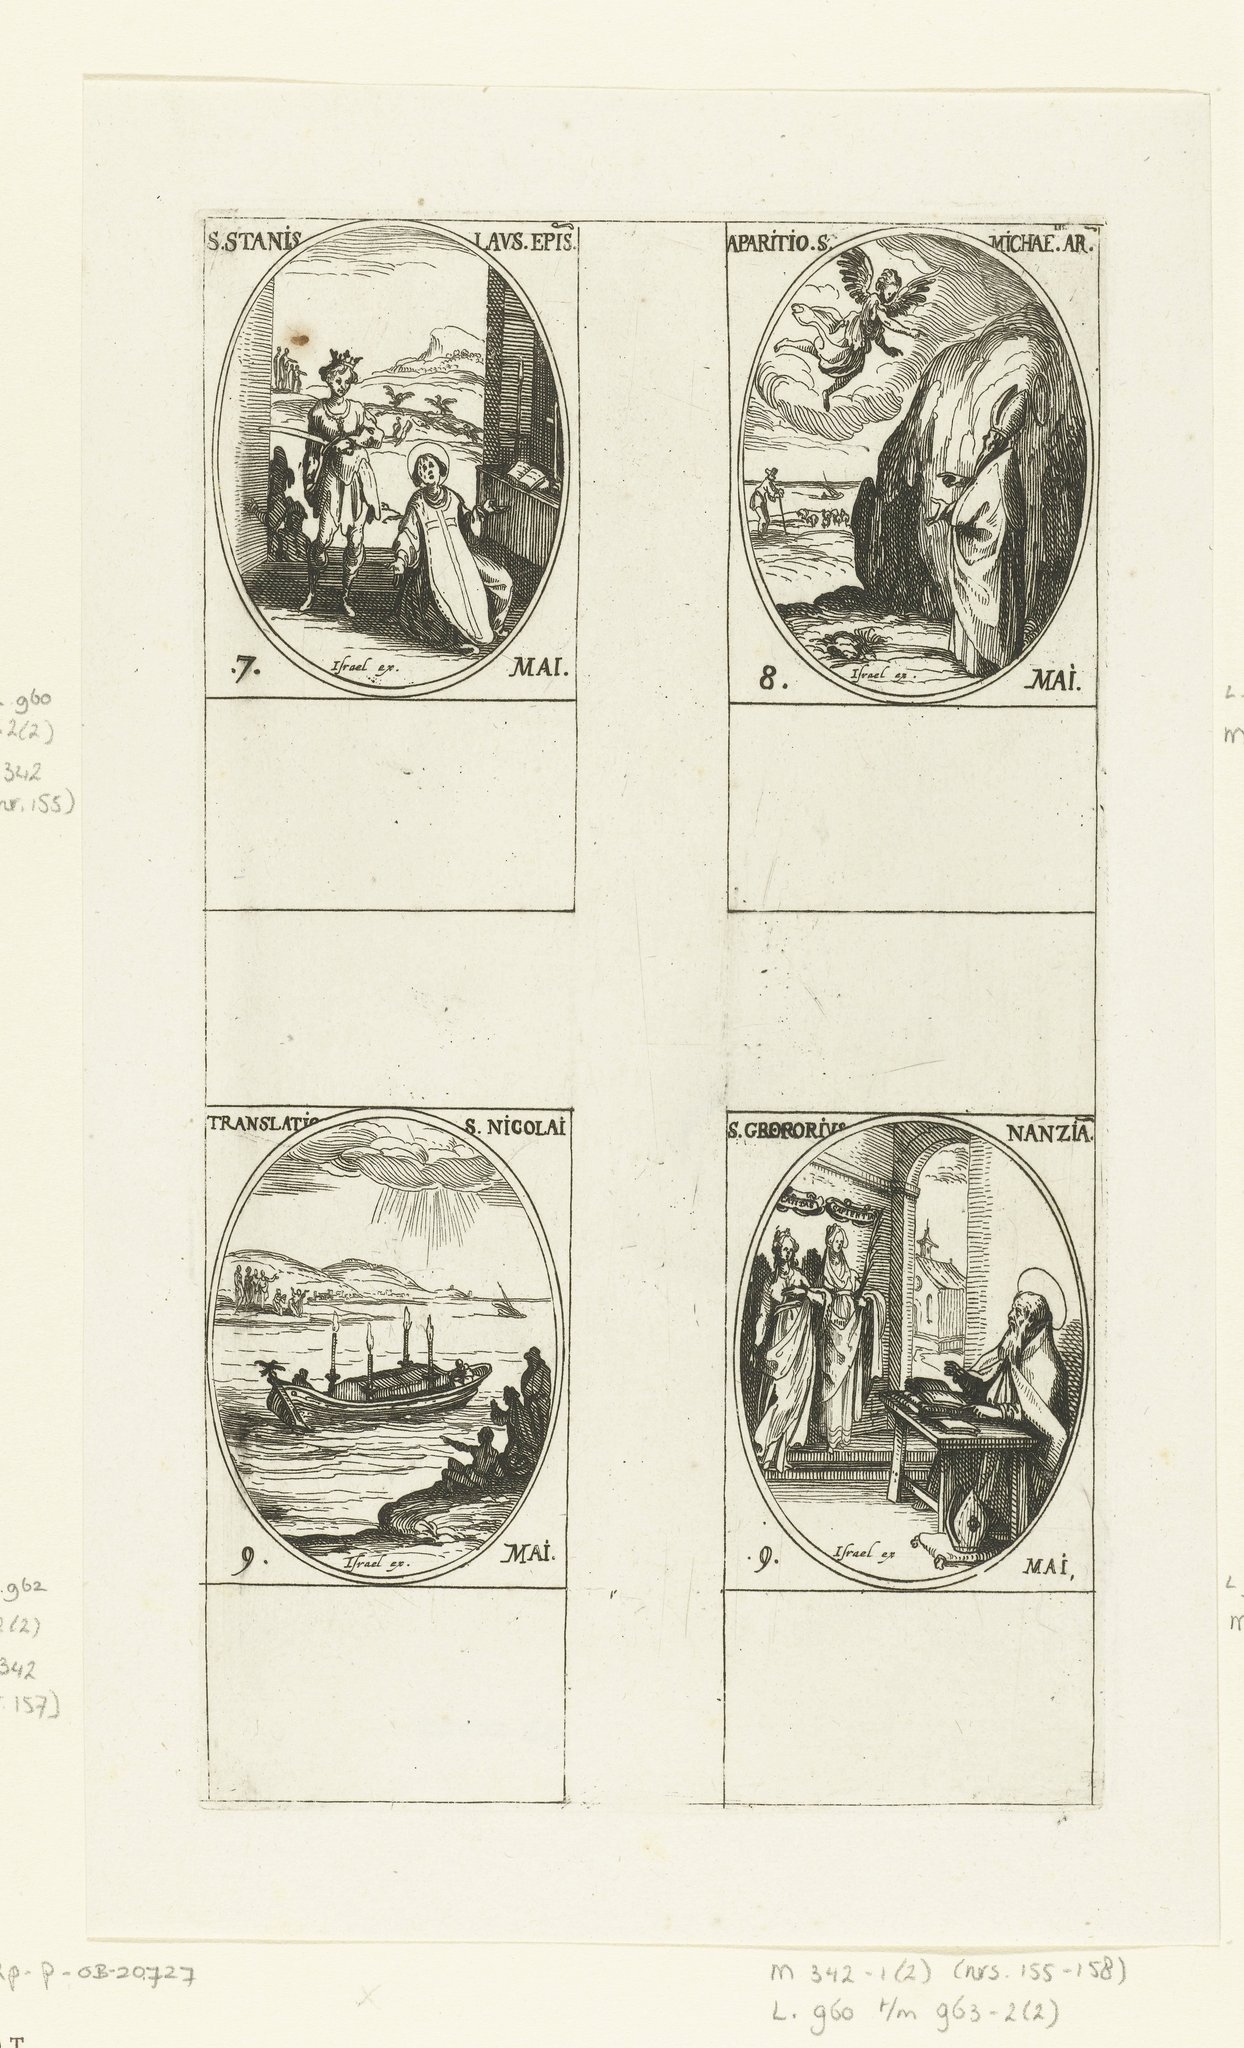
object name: print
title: Alle heiligen en de Christelijke feestdagen van het jaar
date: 1632-1636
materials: paper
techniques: etching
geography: paris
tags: the bishop nicholas of myra (or bari); possible attributes: anchor, boat, three golden balls (on a book), three purses, three children in a tub, three maidens, the monk and bishop gregory of nazianzus, also called the theologian; possible attributes: book, scroll, on mount gargano the archangel michael appears to garganus, the bishop of siponte, who had shot an arrow at a bull, male saints (with name)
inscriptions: collector's mark: Lugt 240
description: Blad met vier ovale voorstellingen, elk met opschrift en datum in het Latijn: linksboven de Heilige Stanislaus van Kraków die voor een altaar door een koning wordt aangevallen, rechtsboven de verschijning van aartsengel Michaël op de Monte Gargano in Apulië een een herder en een bisschop, linksonder de kist met de stoffelijke resten van de Heilige Nicolaas van Myra op een boot op het water, rechtsonder de Heilige Gregorius van Nazianze de Jongere aan zijn schrijftafel. Deze prent is onderdeel van een serie prenten met voorstellingen van de heiligen en de christelijke feestdagen van het jaar. Er zijn steeds vier scènes van één plaat op één blad gedrukt. Inclusief bijbehorend titelblad en frontispice gaat het in totaal om 124 platen (490 voorstellingen). De drie platen met de laatste 12 scènes (de veranderlijke christelijke feestdagen) zijn in de derde staat versneden tot 12 kleine plaatjes, en met een apart titelblad uitgegeven.